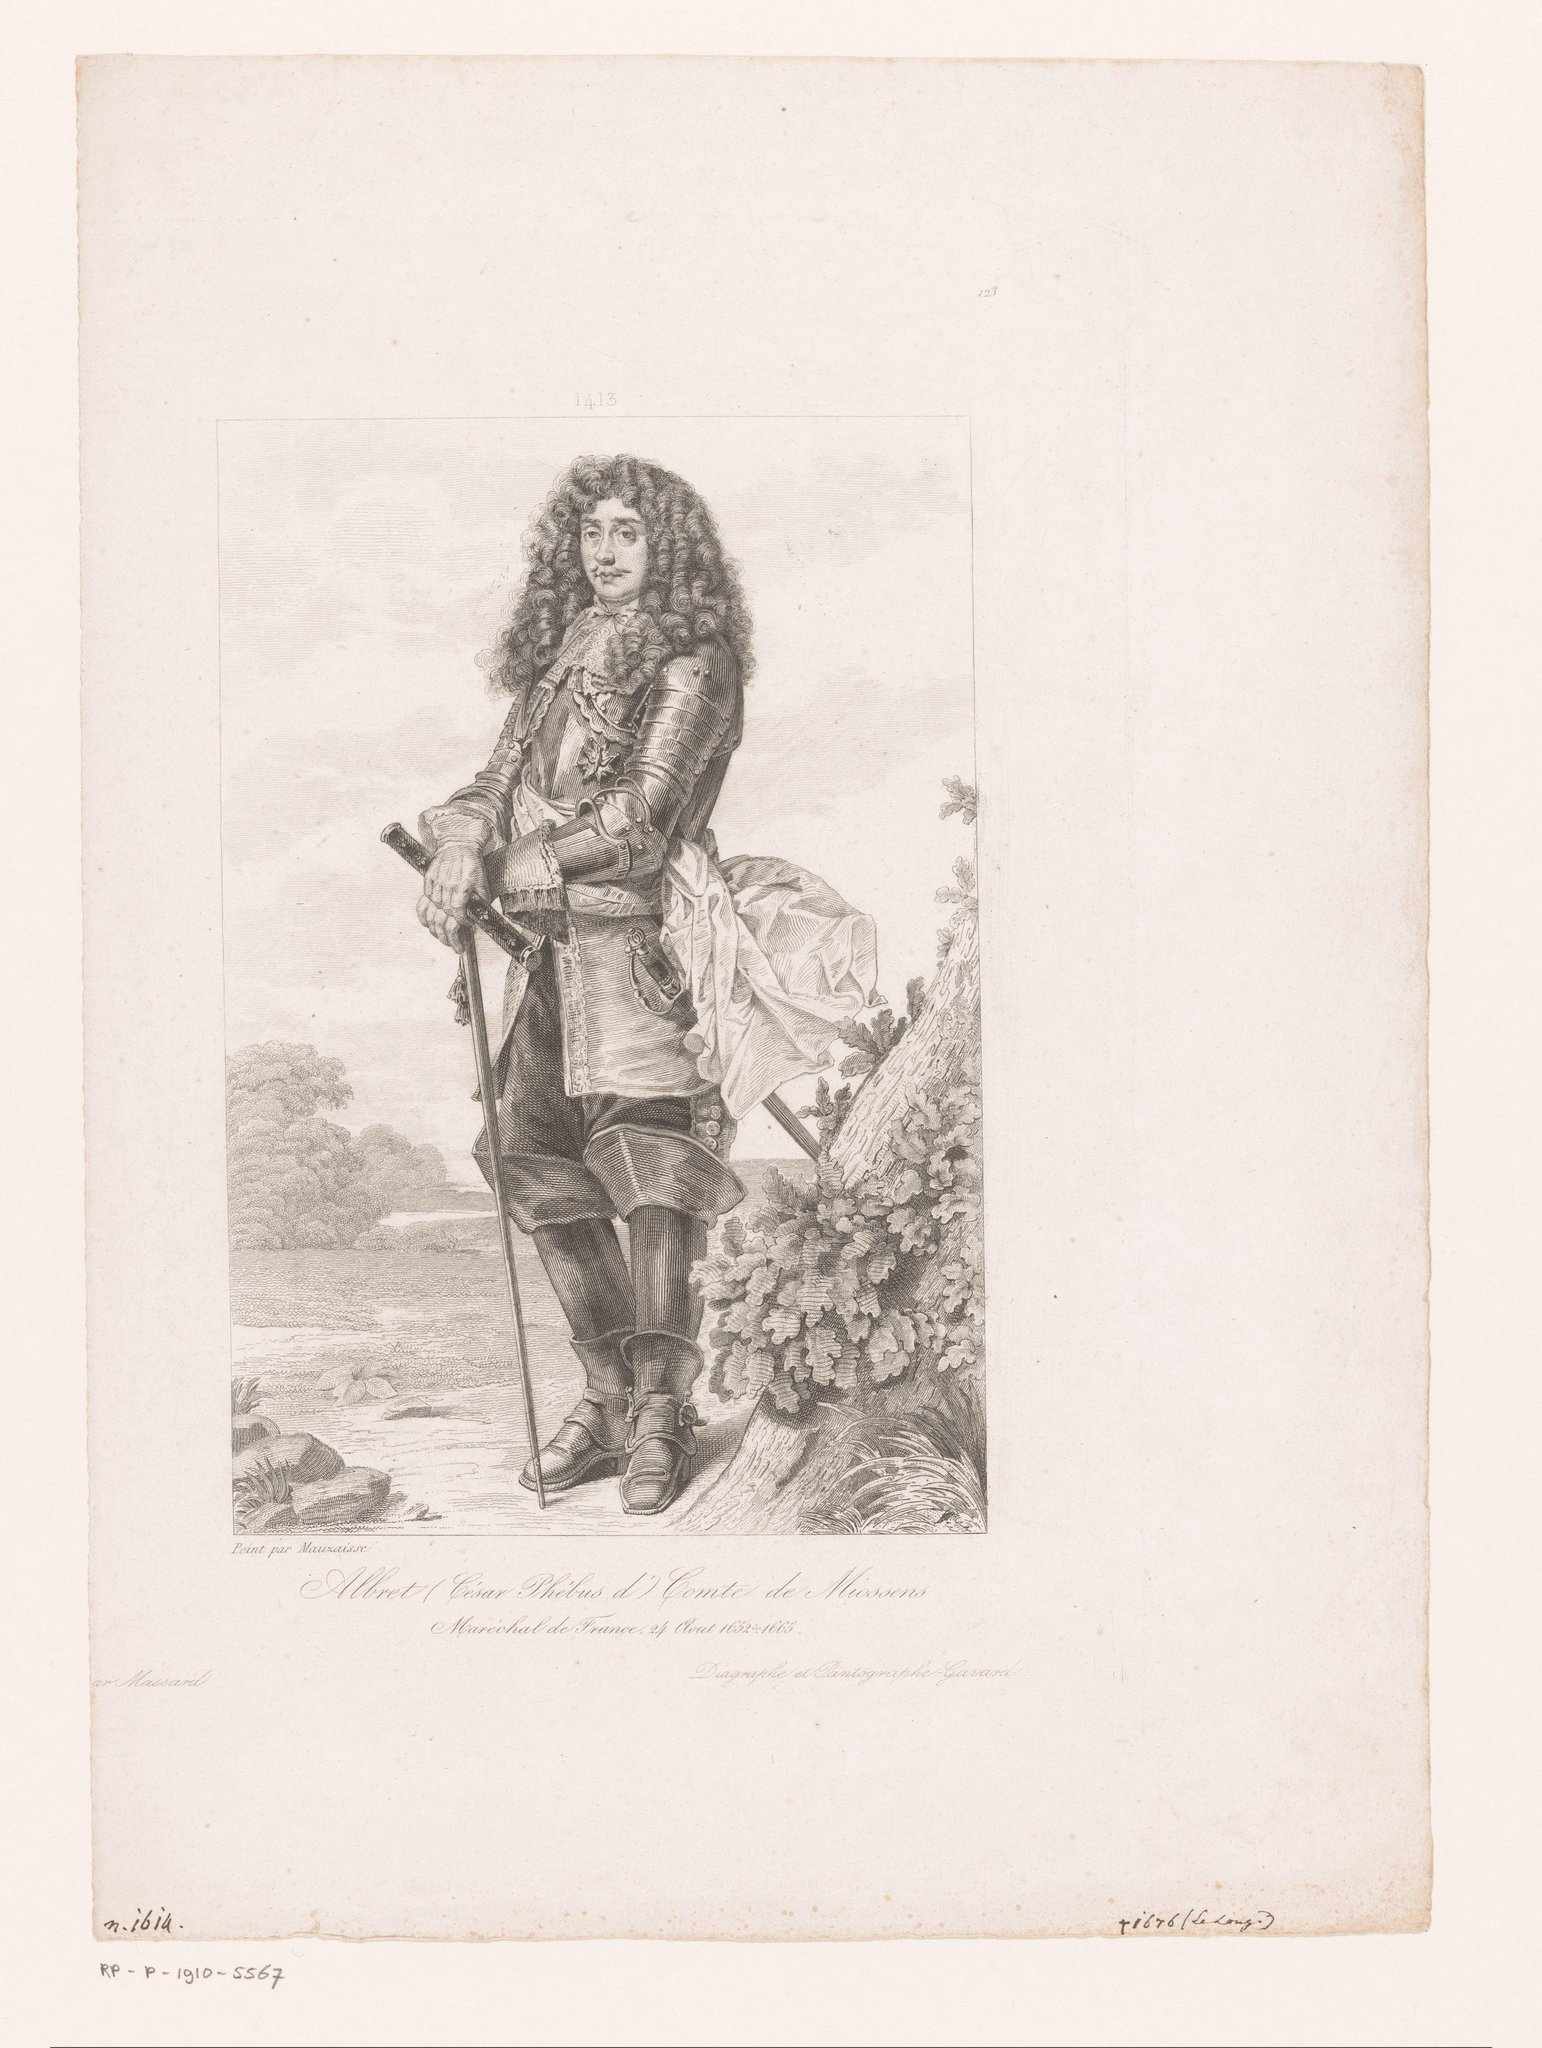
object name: print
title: Portret van César Phoebus d'Albret, graaf van Miossens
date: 1838-1841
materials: paper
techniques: engraving, etching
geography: paris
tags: earl, commander-in-chief, general, marshal, historical persons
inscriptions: collector's mark: Lugt 2228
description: Prent uit: Galeries historiques de Versailles. Parijs: Charles Gavard, 1838-1841.